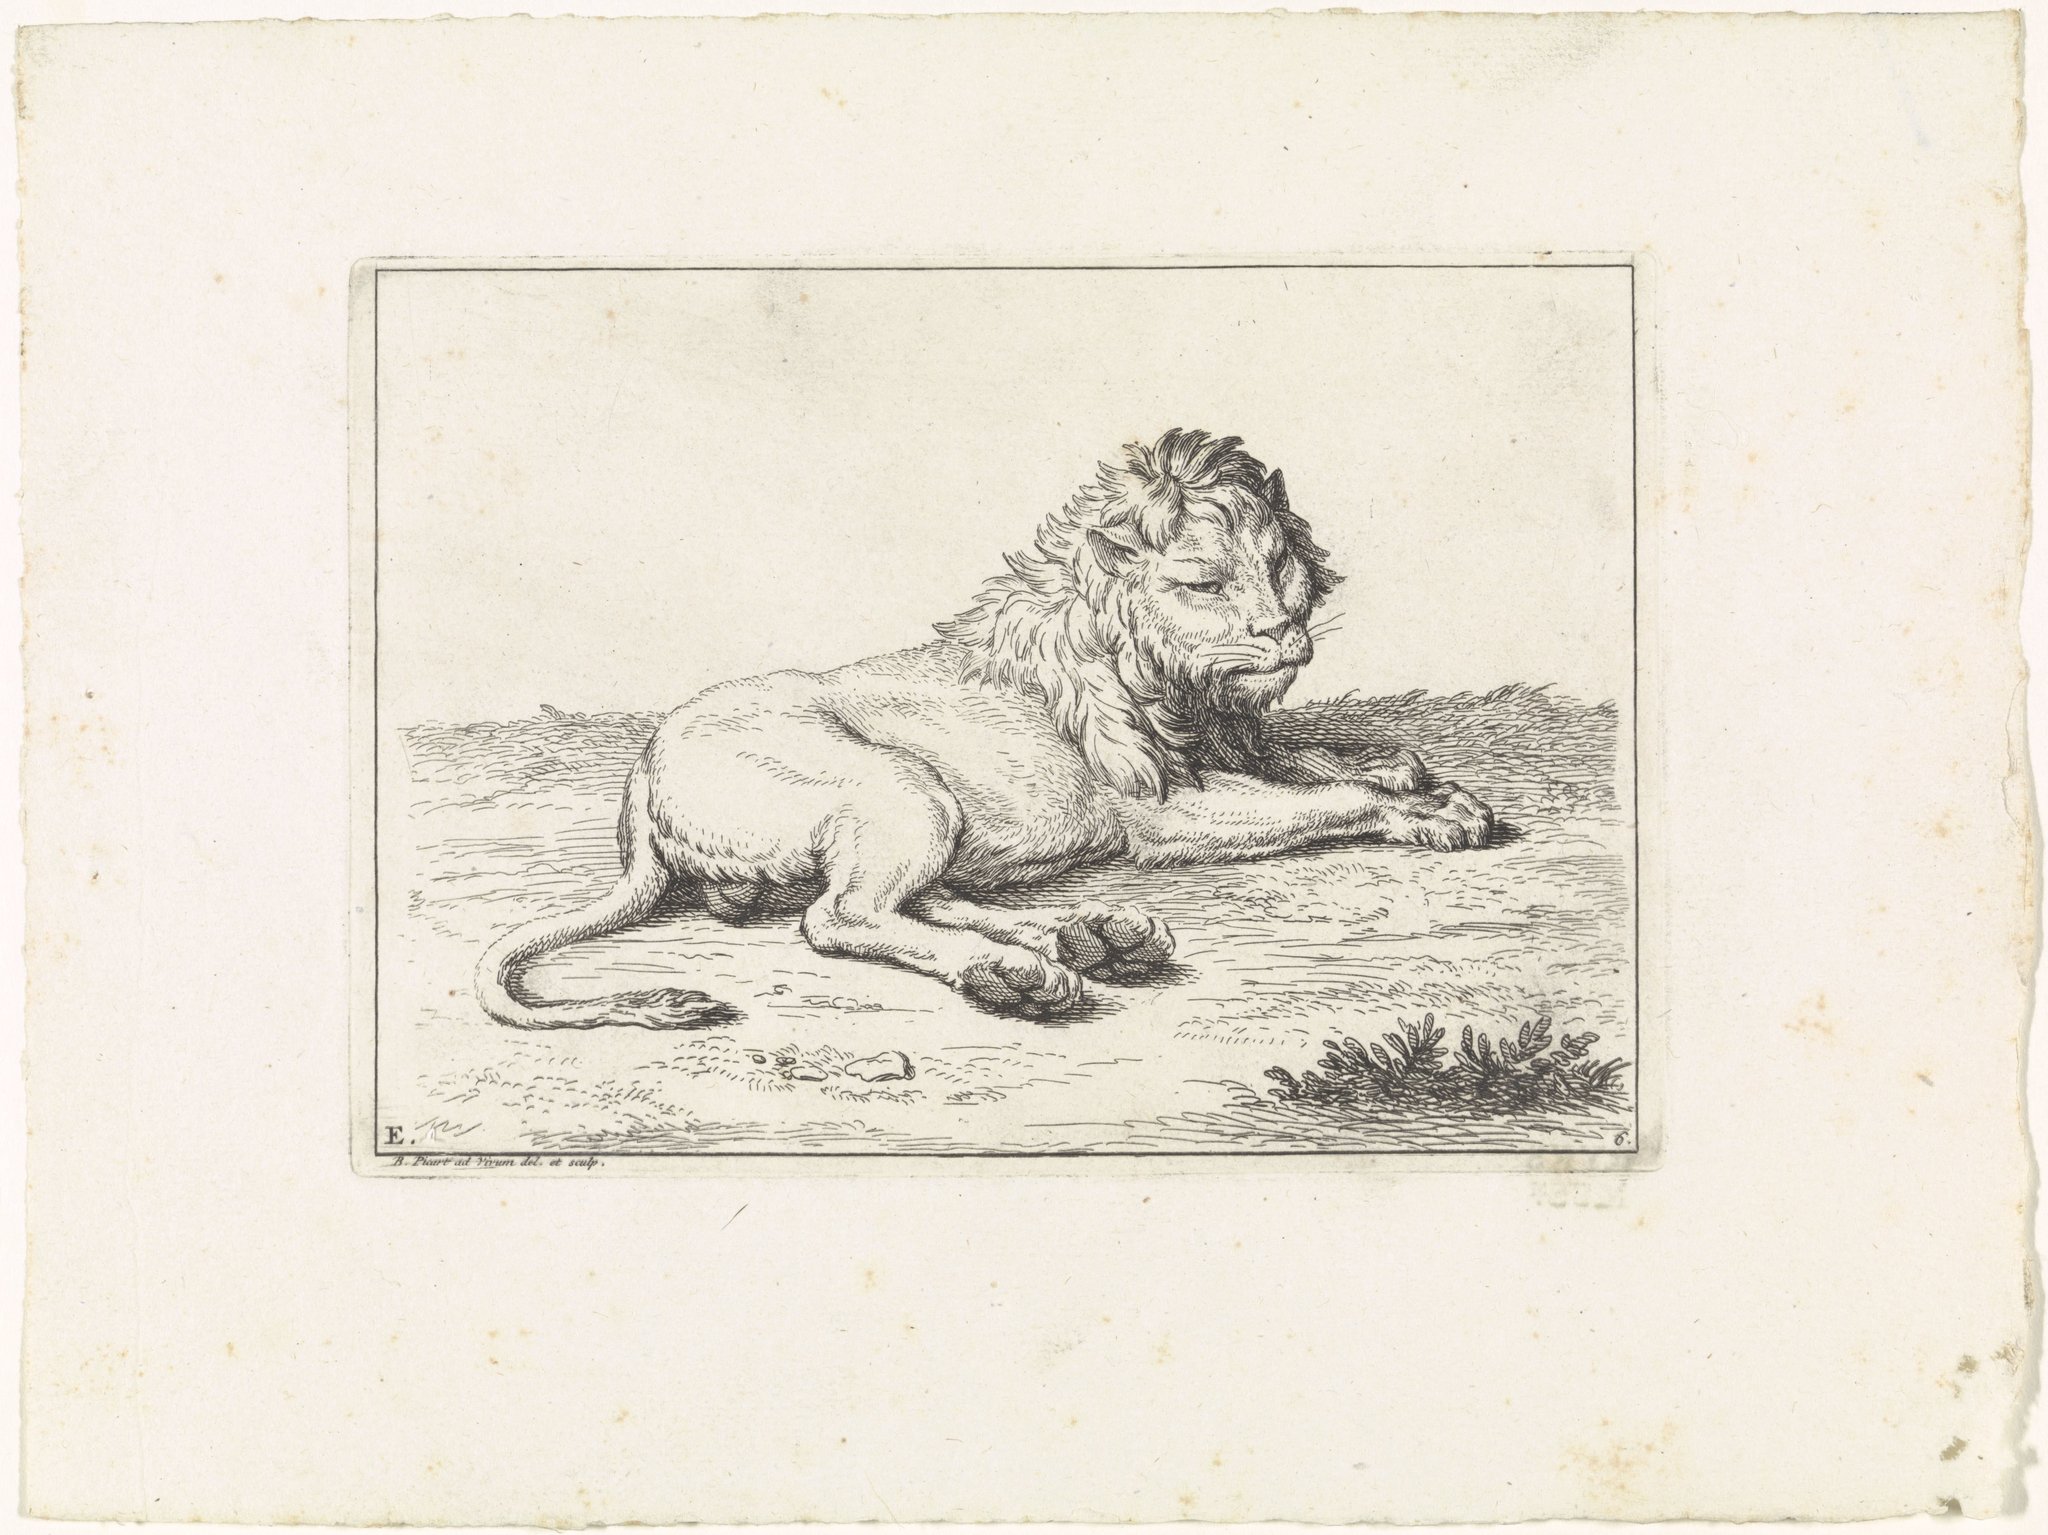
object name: print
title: Landschap met jonge leeuw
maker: bernard picart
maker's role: draughtsman, print maker, publisher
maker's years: 1673-1733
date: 1729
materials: paper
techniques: etching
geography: amsterdam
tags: beasts of prey, predatory animals: lion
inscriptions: collector's mark: Lugt 2165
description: Prent ook als illustratie gebruikt in: Recueil de lions, dessinez d'après nature par divers maitres. Amsterdam: Bernard Picart, 1729.